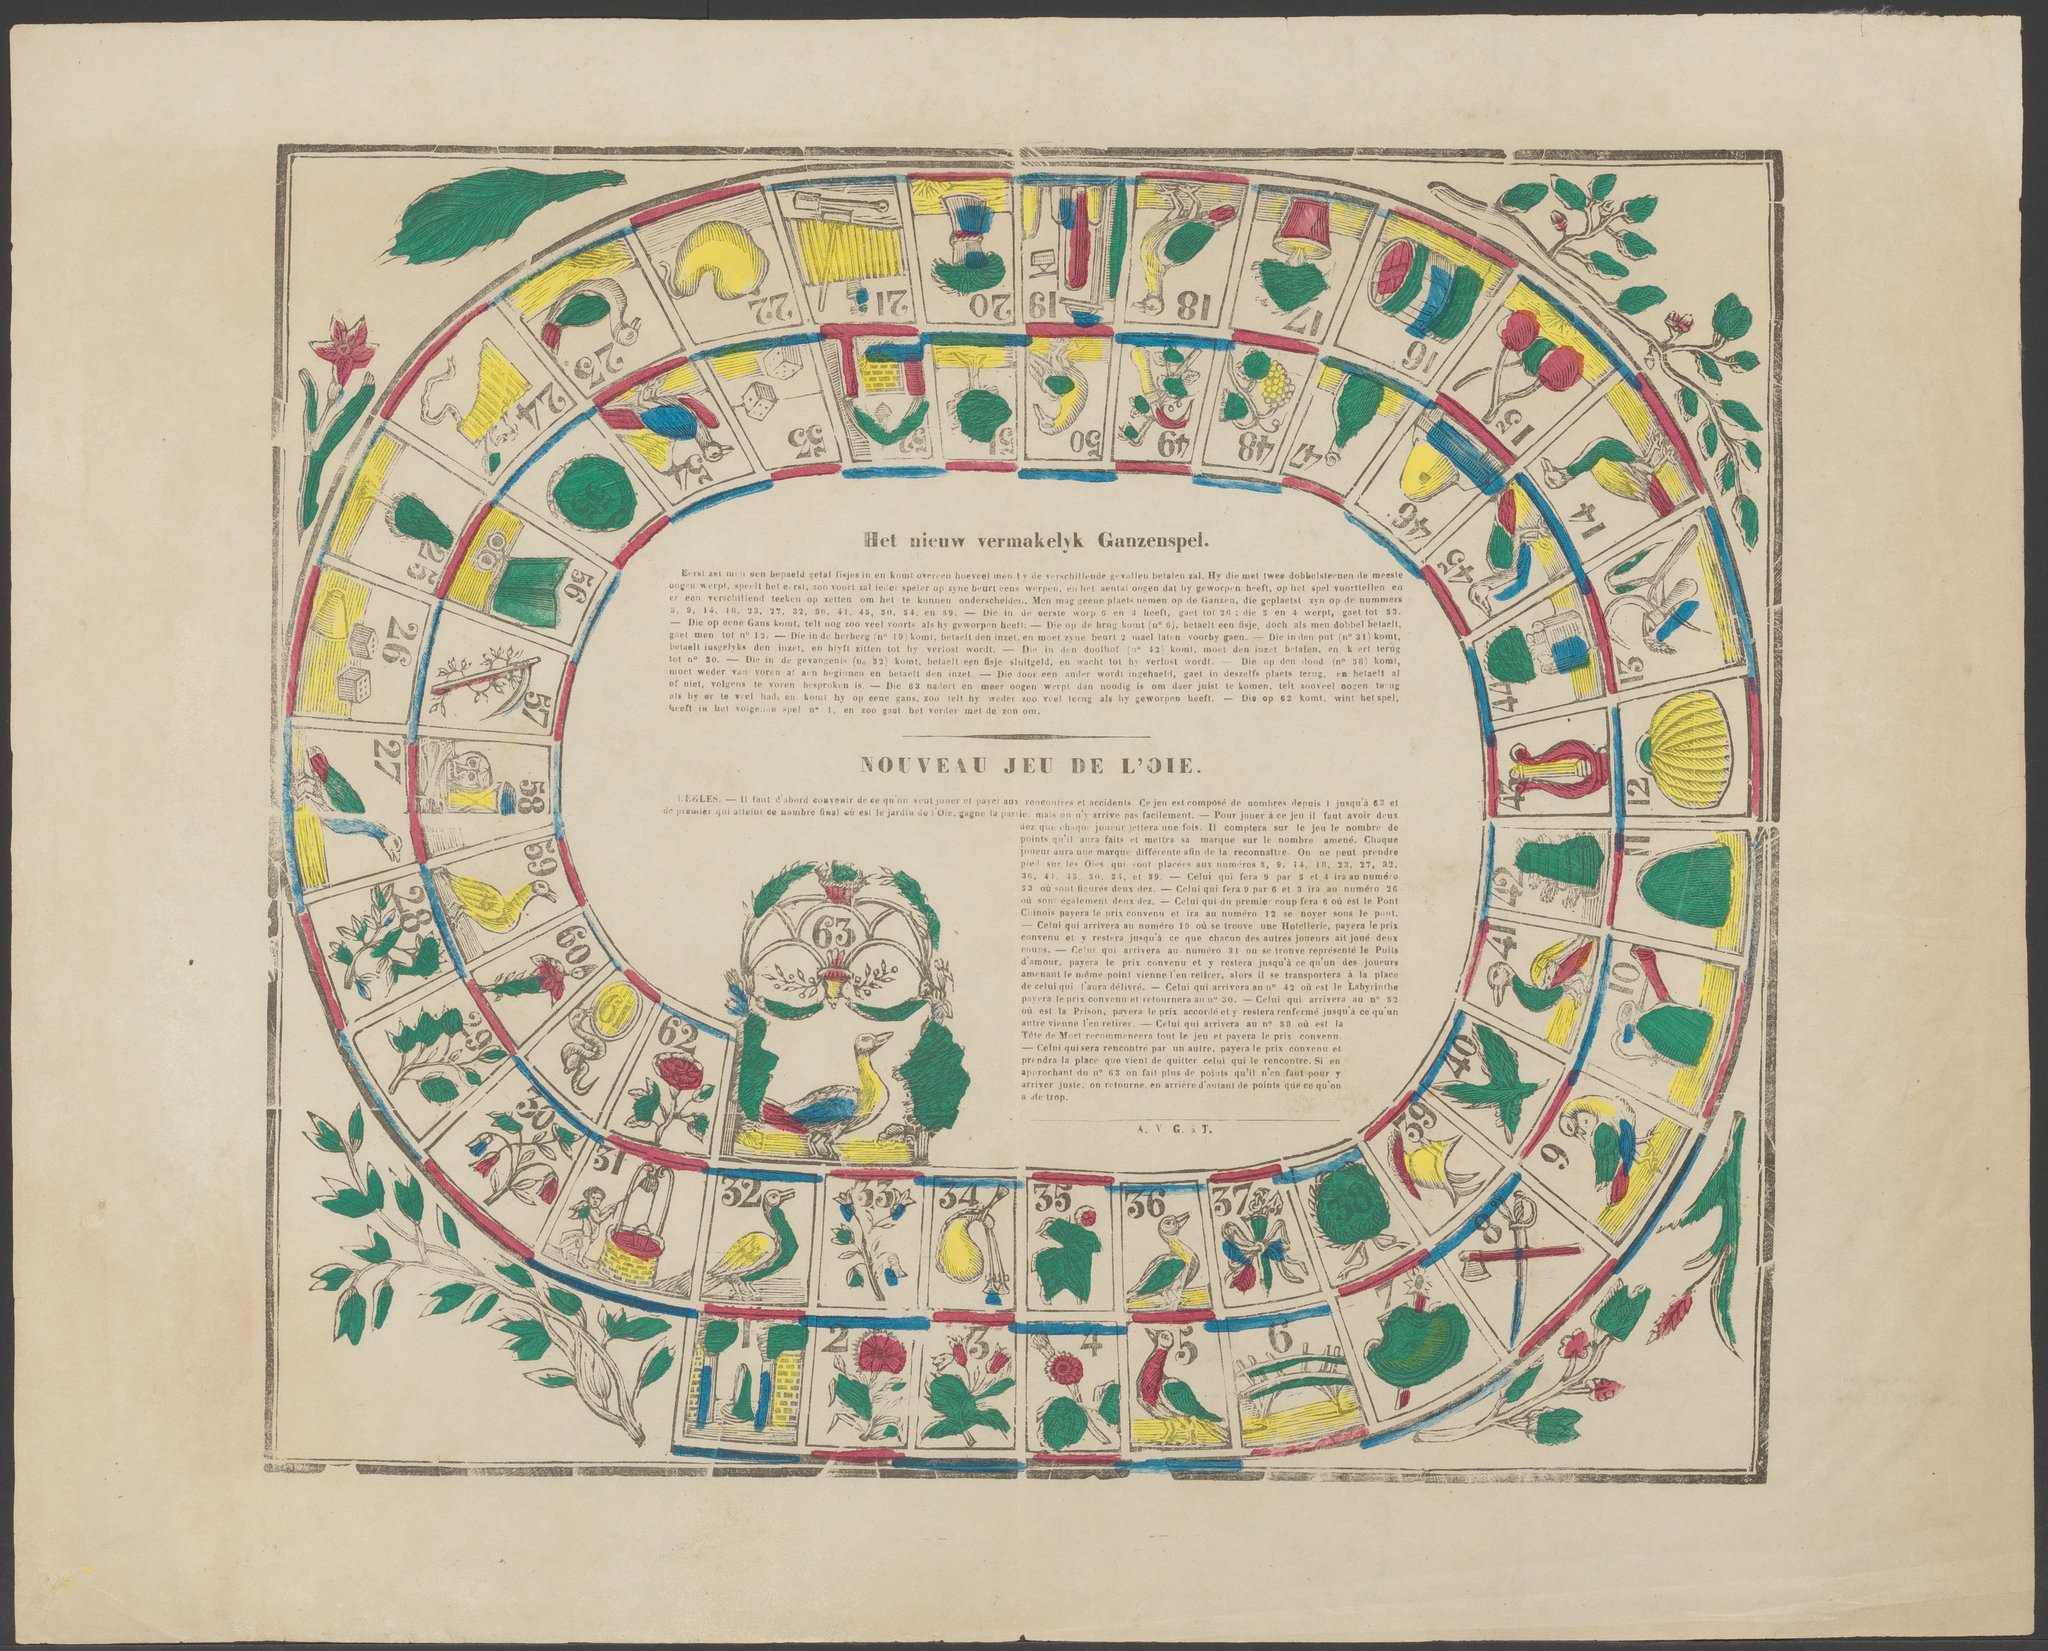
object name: print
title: Speelbord voor ganzenbord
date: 1856-1870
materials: paper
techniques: hand coloring, letterpress printing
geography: turnhout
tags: goose-game, board-games of chance, board-games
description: Ovaal ganzenbordspel met vakken in een spiraal van 1 tot 63. In de vier hoeken takken en bloemen. Middenin een gans onder een erepoort en de spelregels in het Nederlands en in het Frans. Onderwerpsrubrieken binnen de Atlas Zeden en Gewoonten: Zeden en gewoonten in engeren zin, Spel en vermaak, Gezelschapsspel II, Ganzenbord en dergelijke.